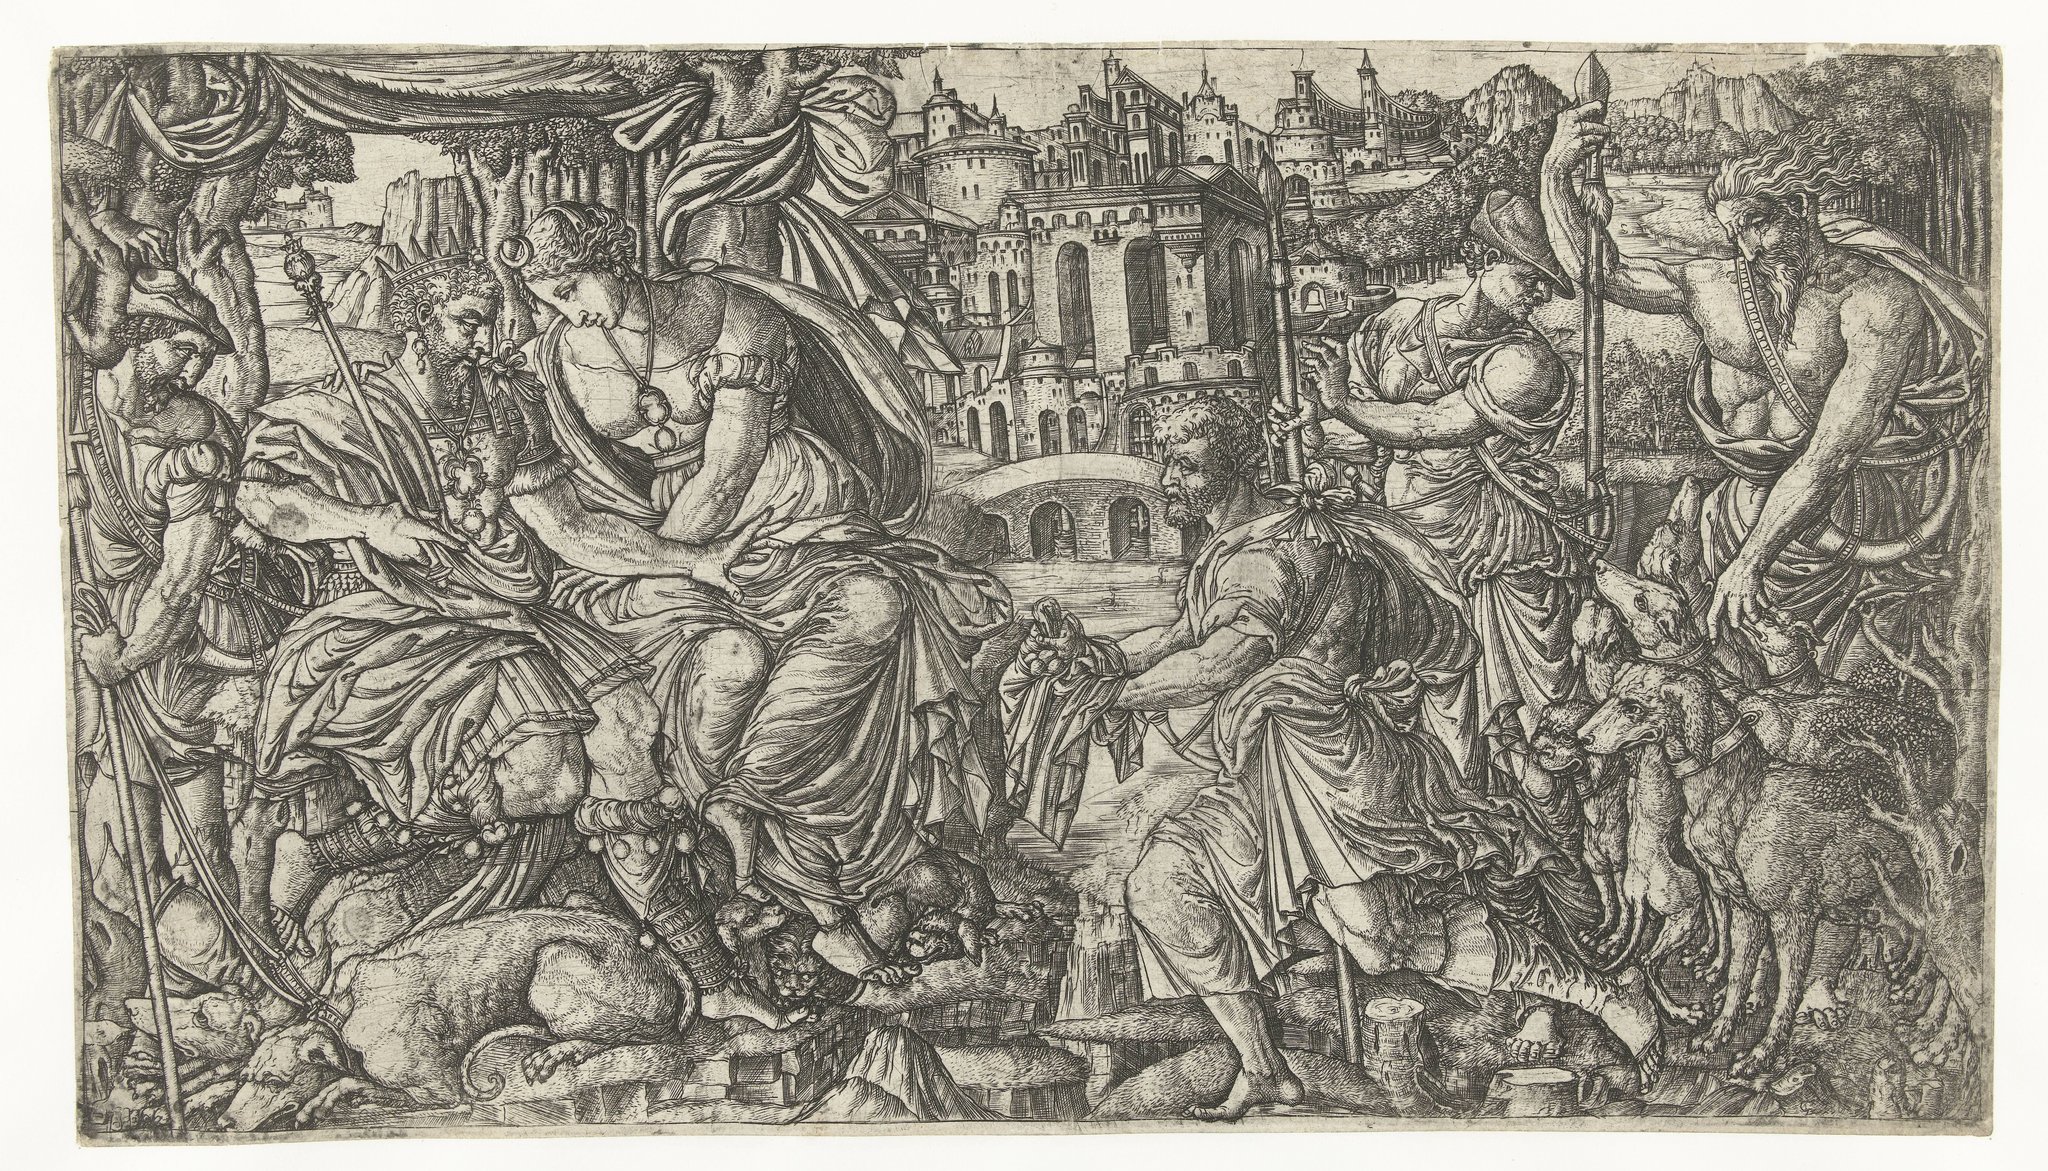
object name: print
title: De eenhoorn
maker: jean duvet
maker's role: print maker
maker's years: 1485-1561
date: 1540-1550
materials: paper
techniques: engraving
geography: france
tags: (story of) diana (artemis), hunter, king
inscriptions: collector's mark: Lugt 240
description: In een landschap drie jagers met honden, waarvan één een geschenk aanbiedt aan de koning. Deze reikt met zijn hand naar het geschenk. Diana, de godin van de jacht zit naast hem. Eerste prent uit een serie van zes.